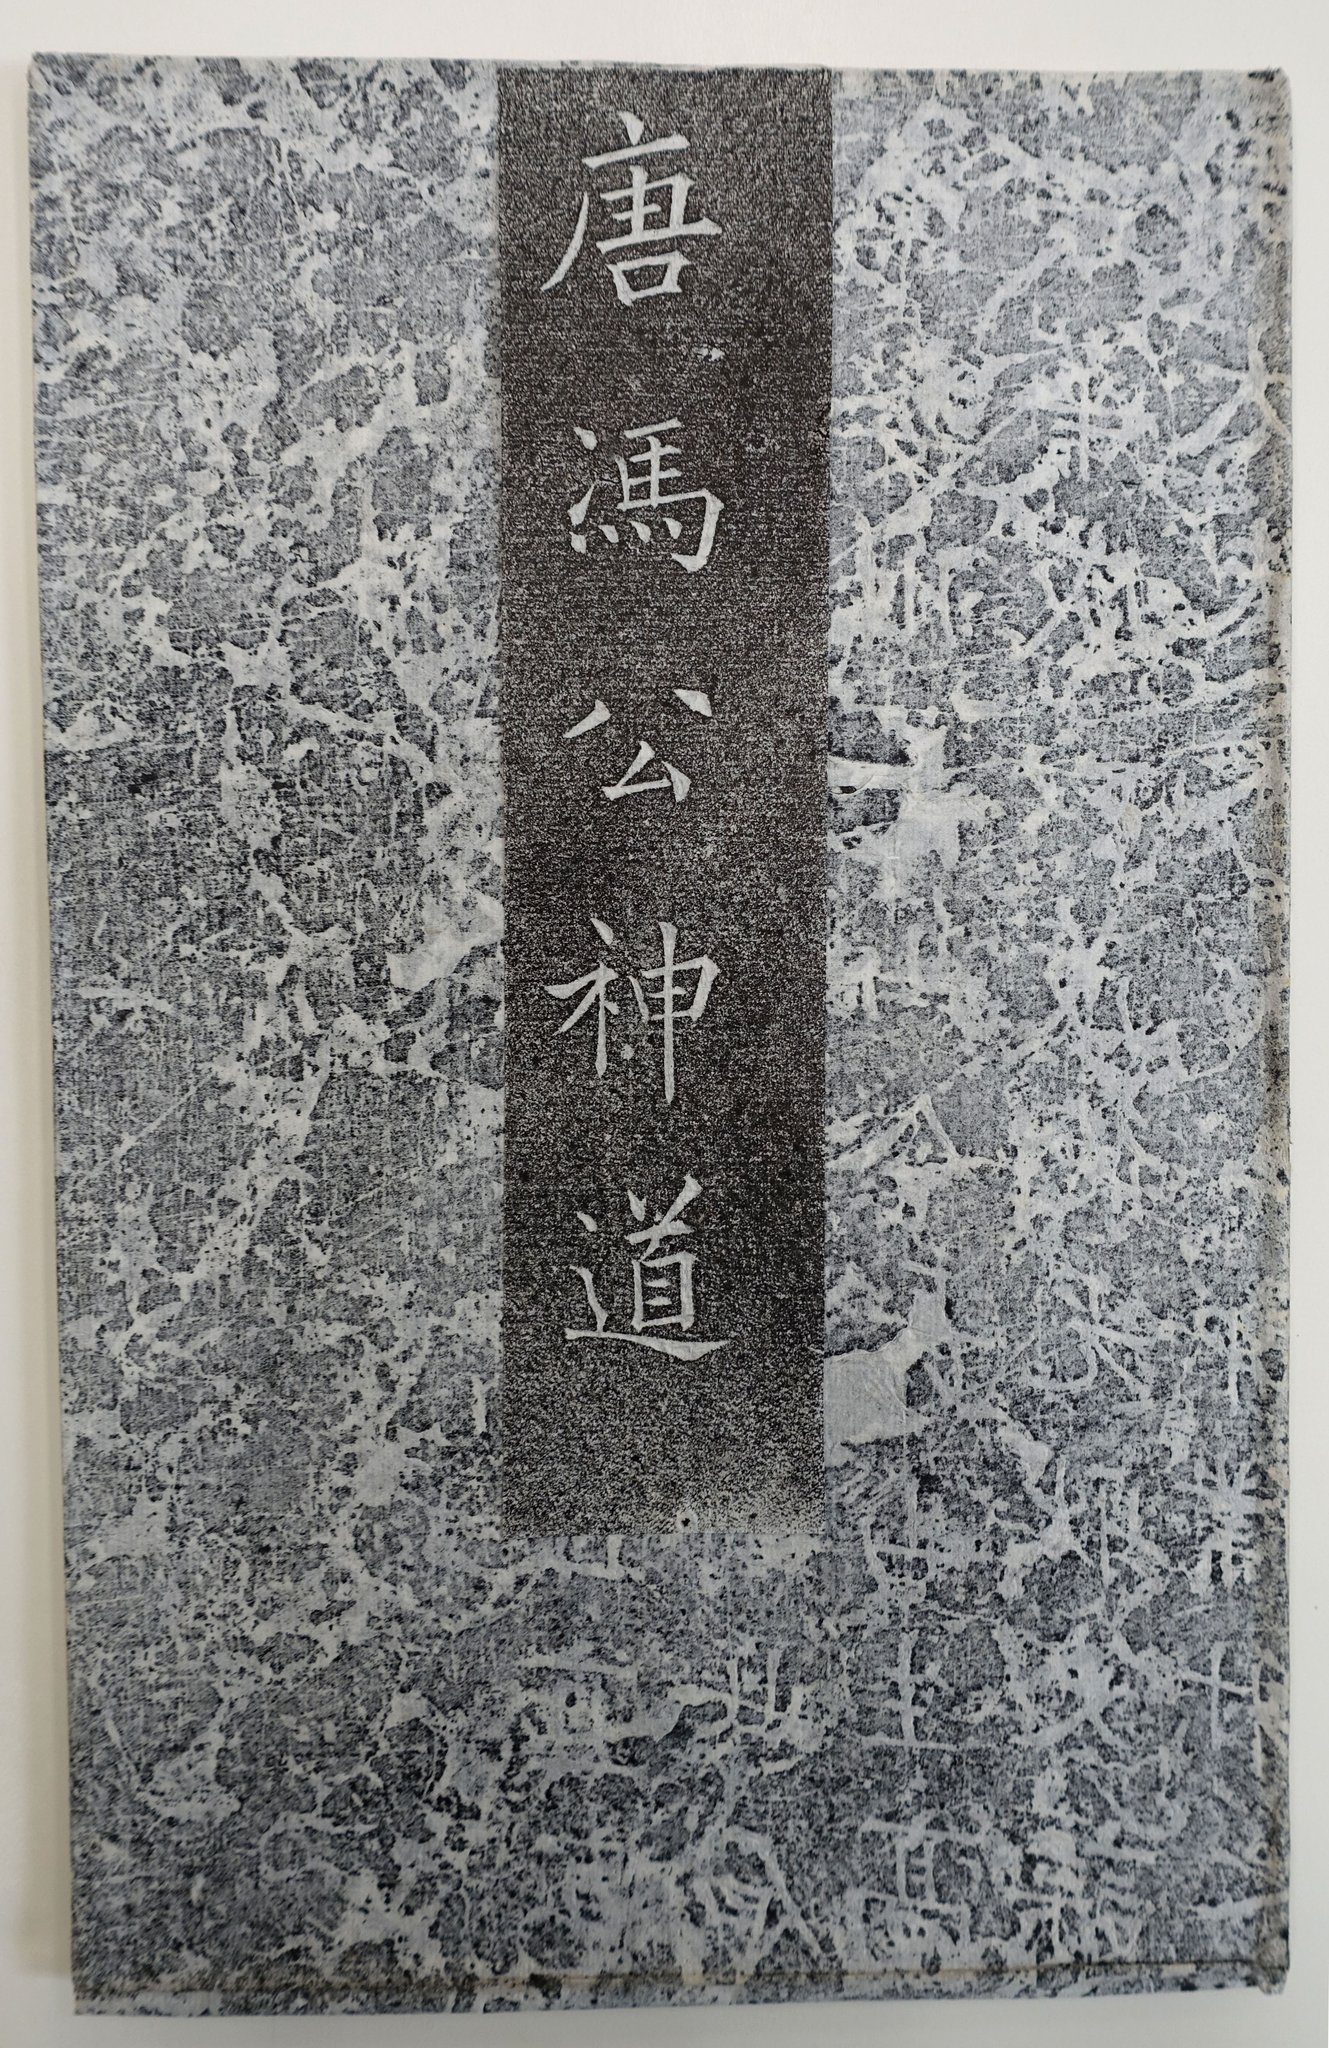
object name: rubbing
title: Stele for the "Spirit Road" (leading to the tomb of) Feng Su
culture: chinese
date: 1901-2000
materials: ink, paper